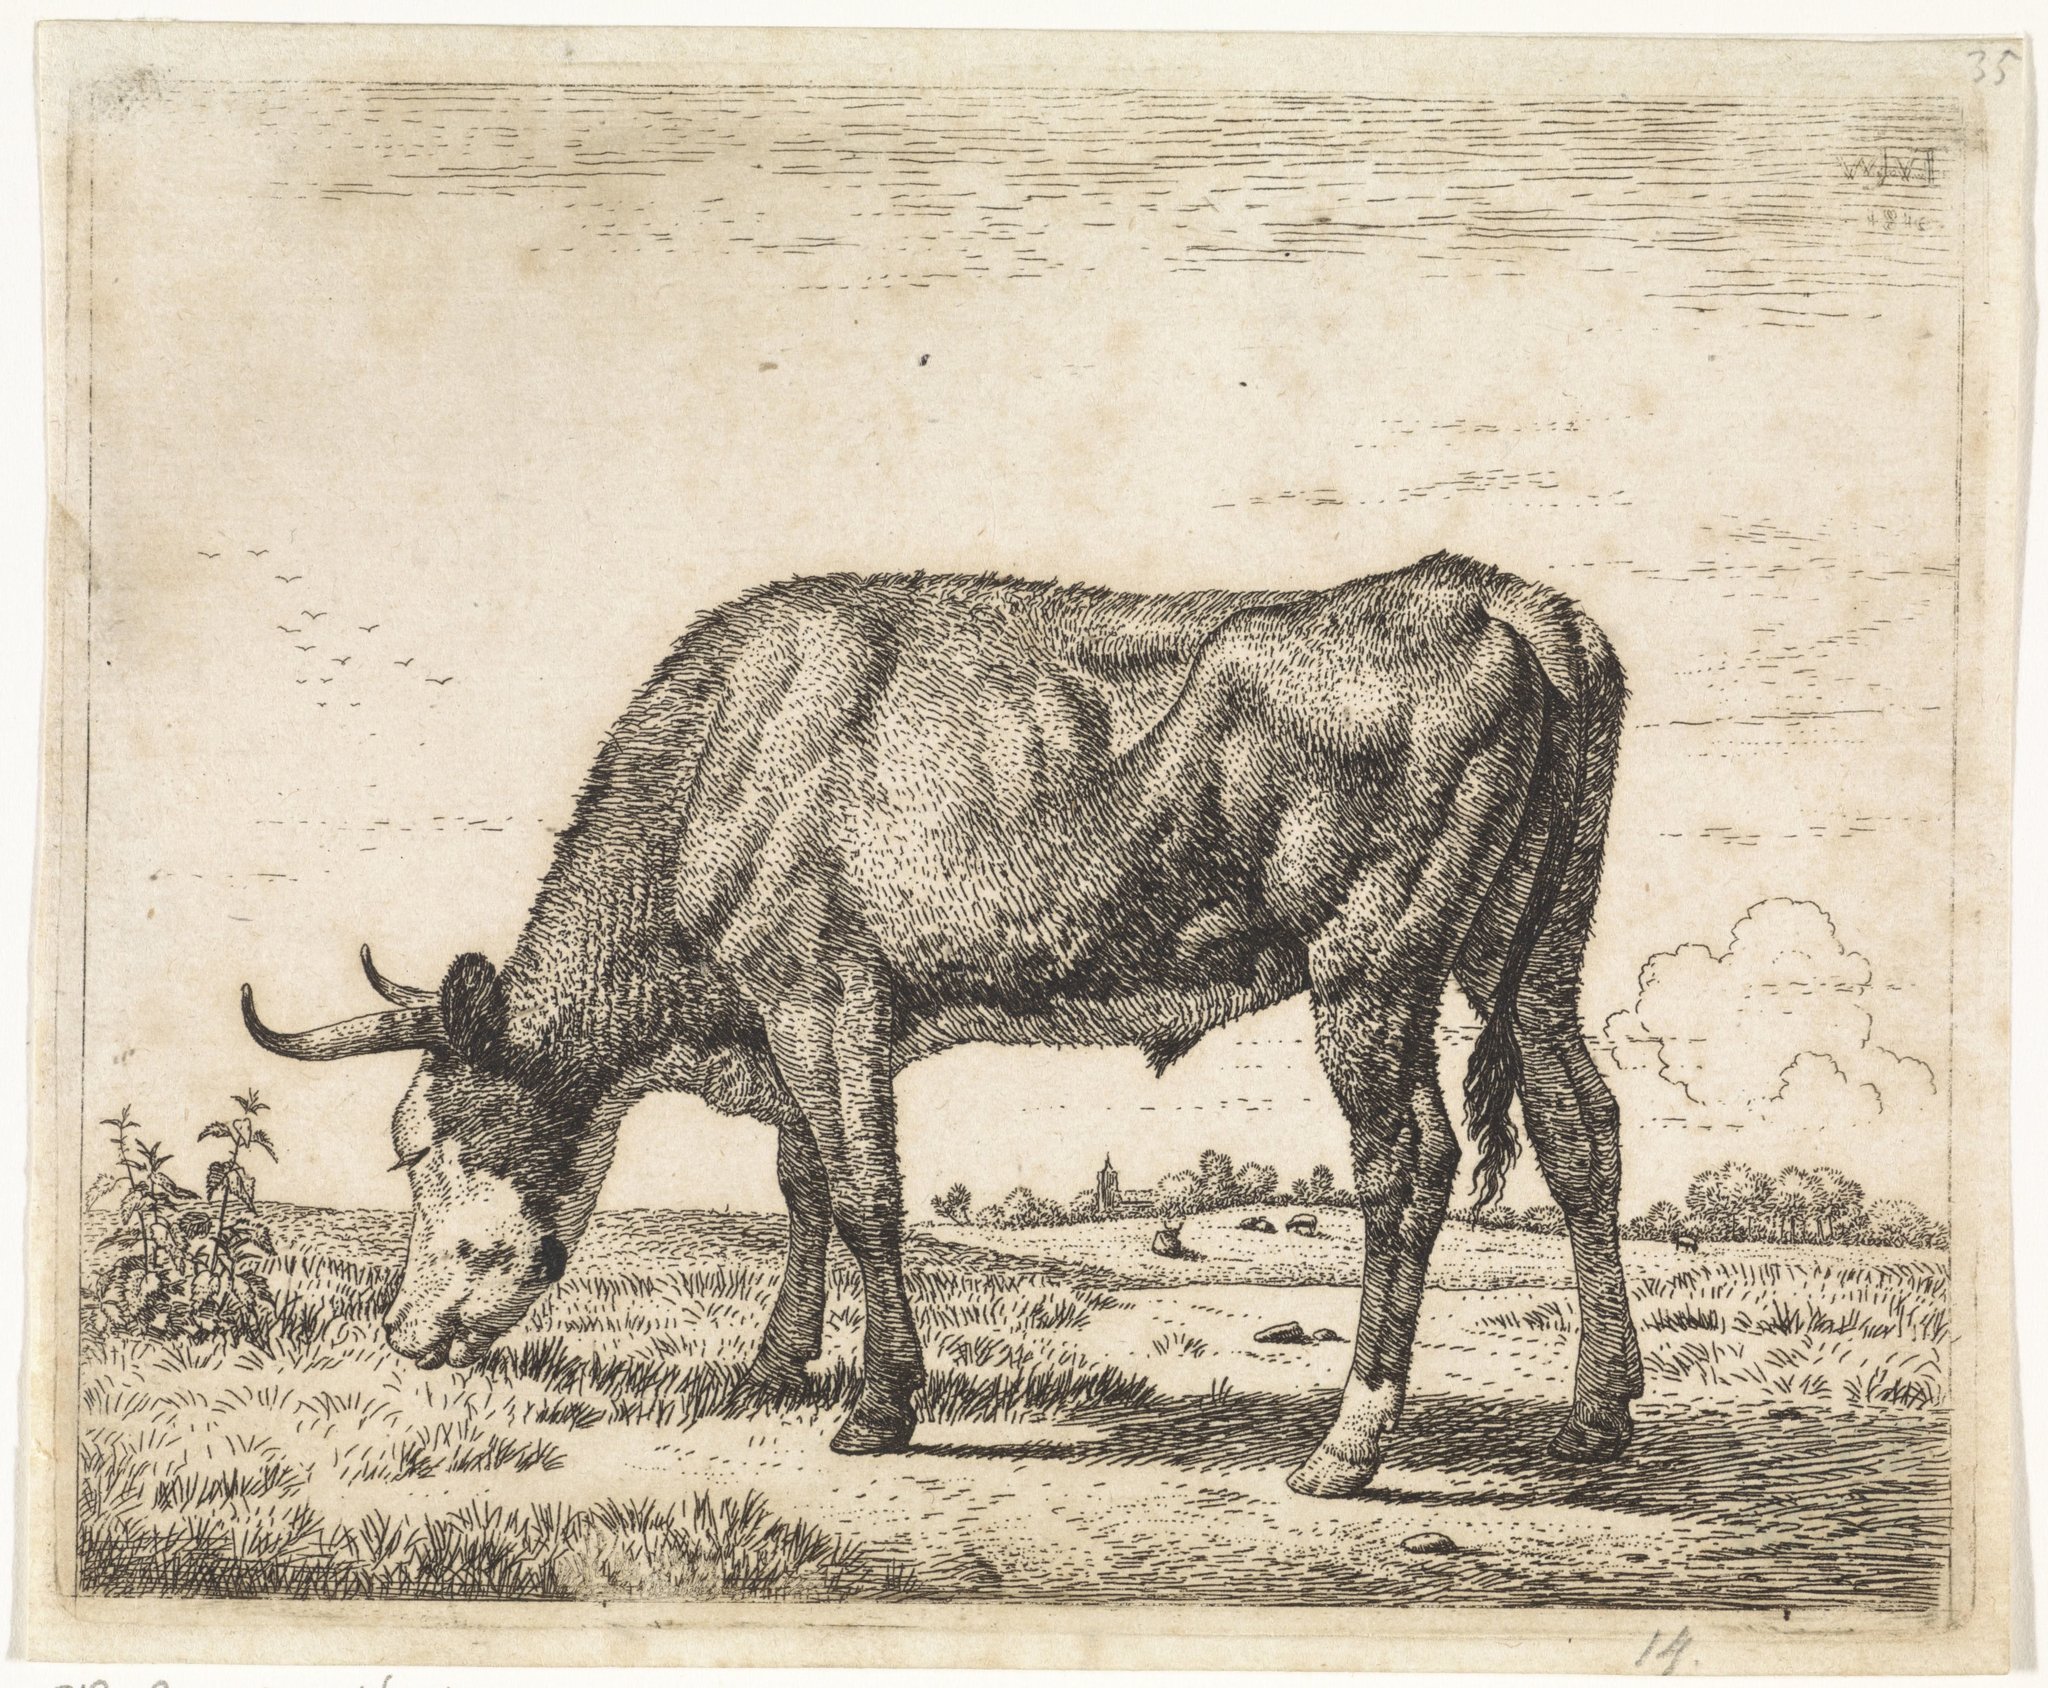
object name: print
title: Grazende koe naar links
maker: wouter johannes van troostwijk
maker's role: draughtsman, painter, print maker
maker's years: 1782-1810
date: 1810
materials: paper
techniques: etching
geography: amsterdam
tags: cow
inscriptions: collector's mark: Lugt 2165